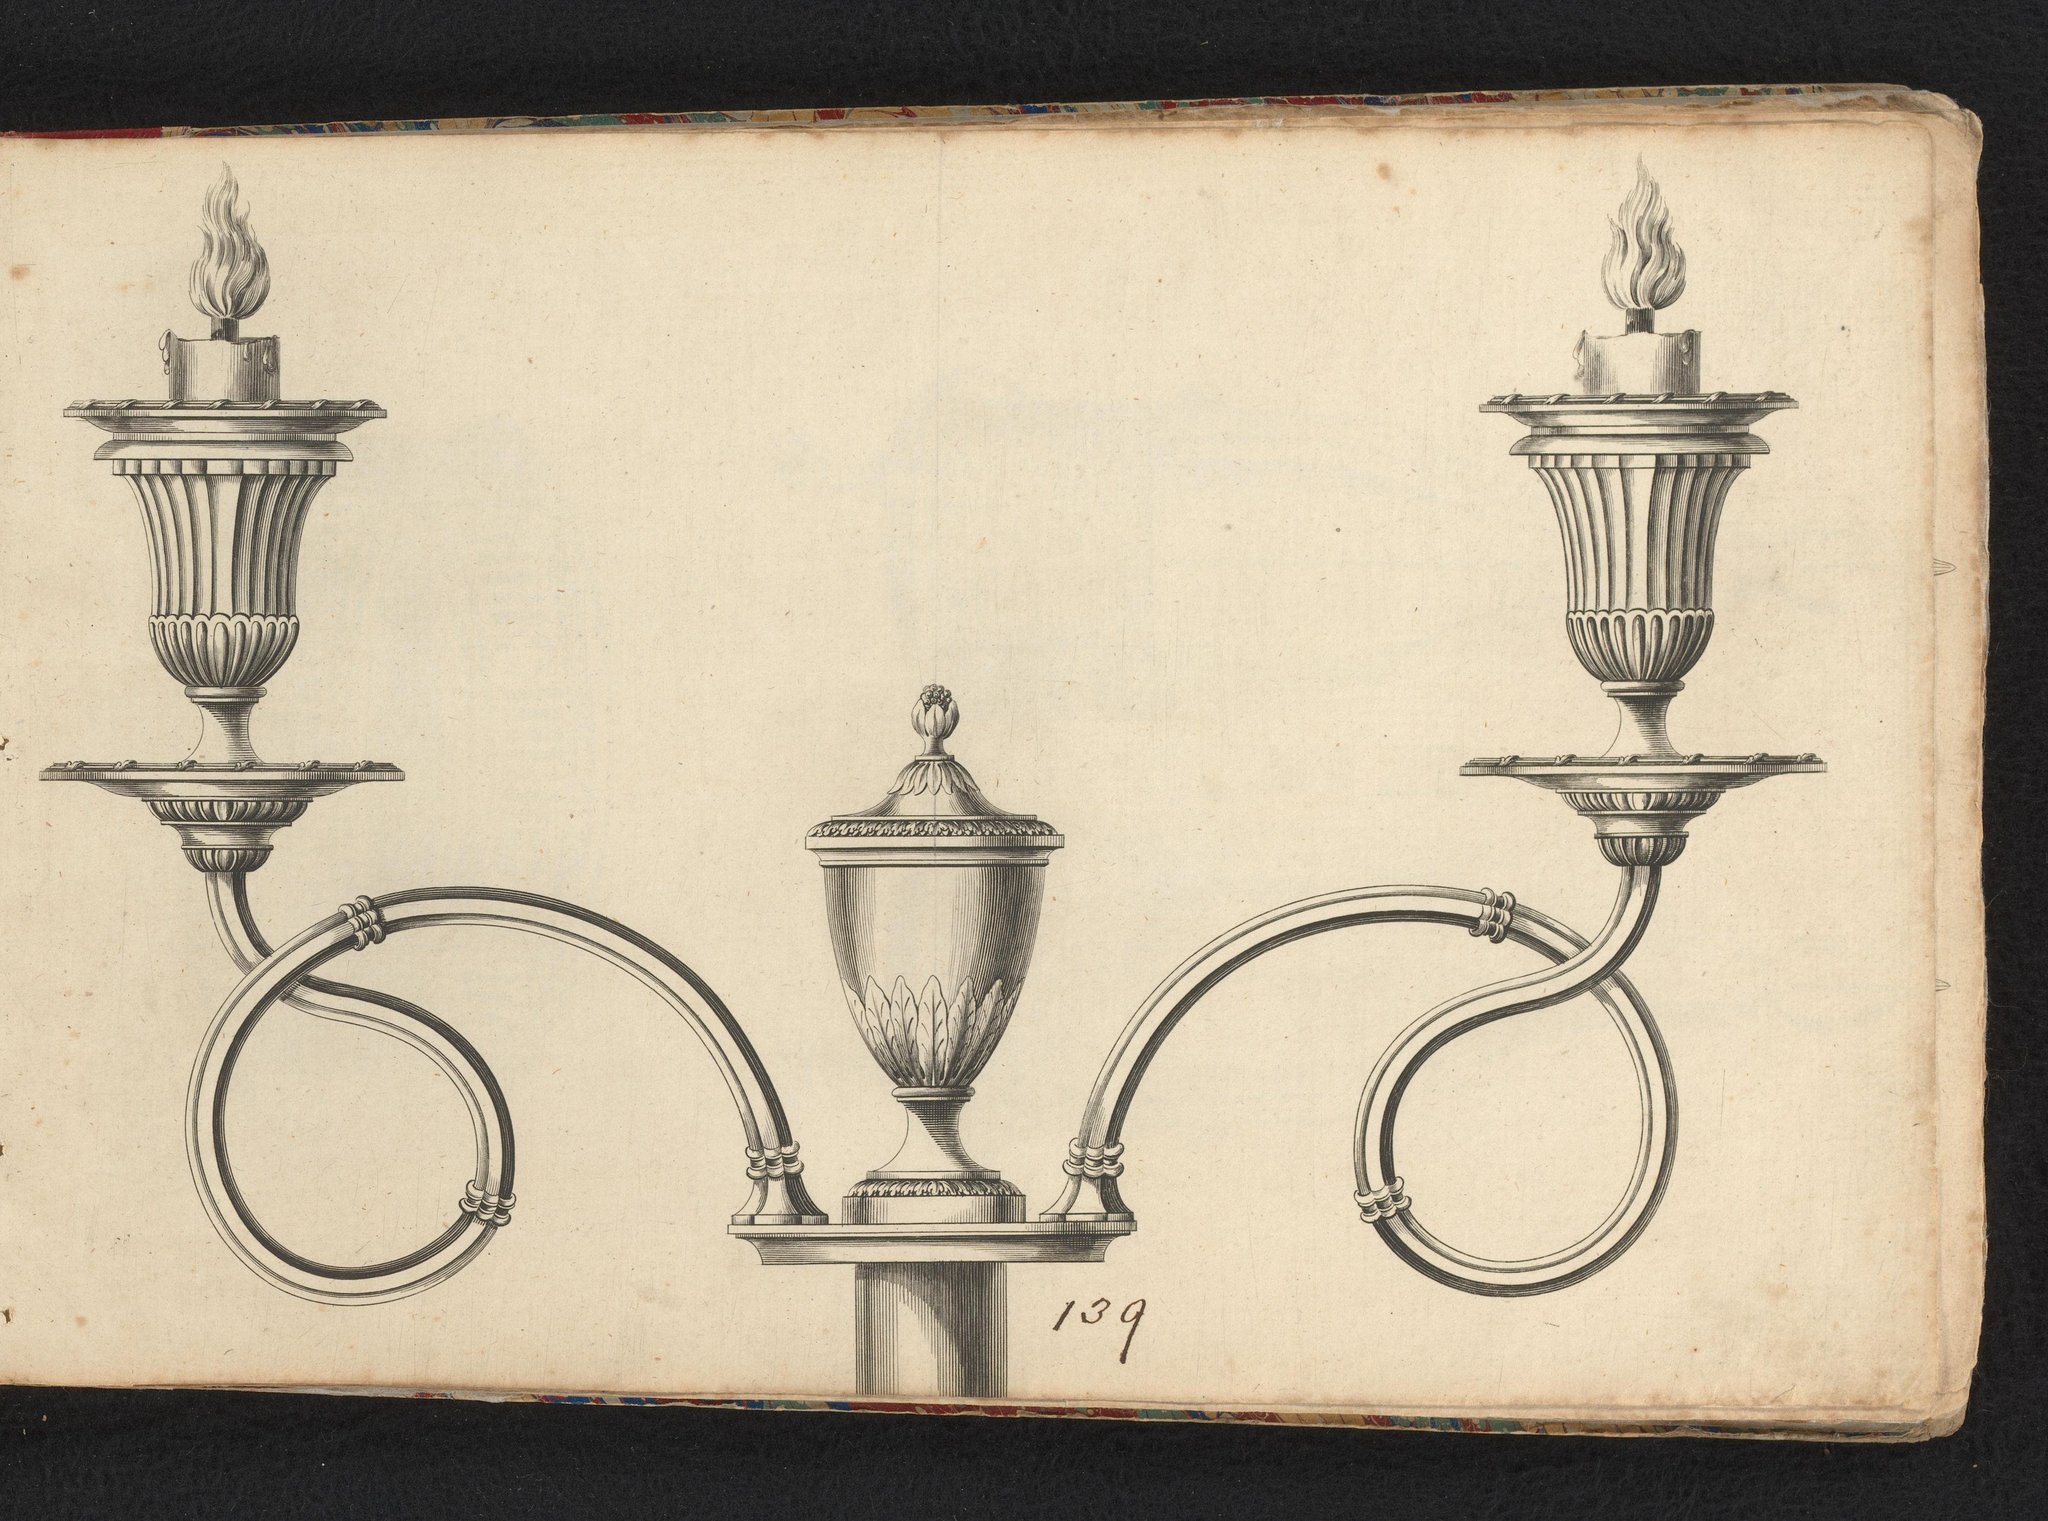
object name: ornament print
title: Ontwerp voor een kandelaar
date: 1784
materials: paper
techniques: engraving, etching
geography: england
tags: chandelier, candelabrum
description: Ontwerp voor een kandelaar voor twee kaarsen, op het volle blad. Onderaan handgeschreven nr. 139. Onderdeel van een catalogus met assortiment modellen van Sheffield verzilverd vaatwerk (pleet) door Matthew Boulton.